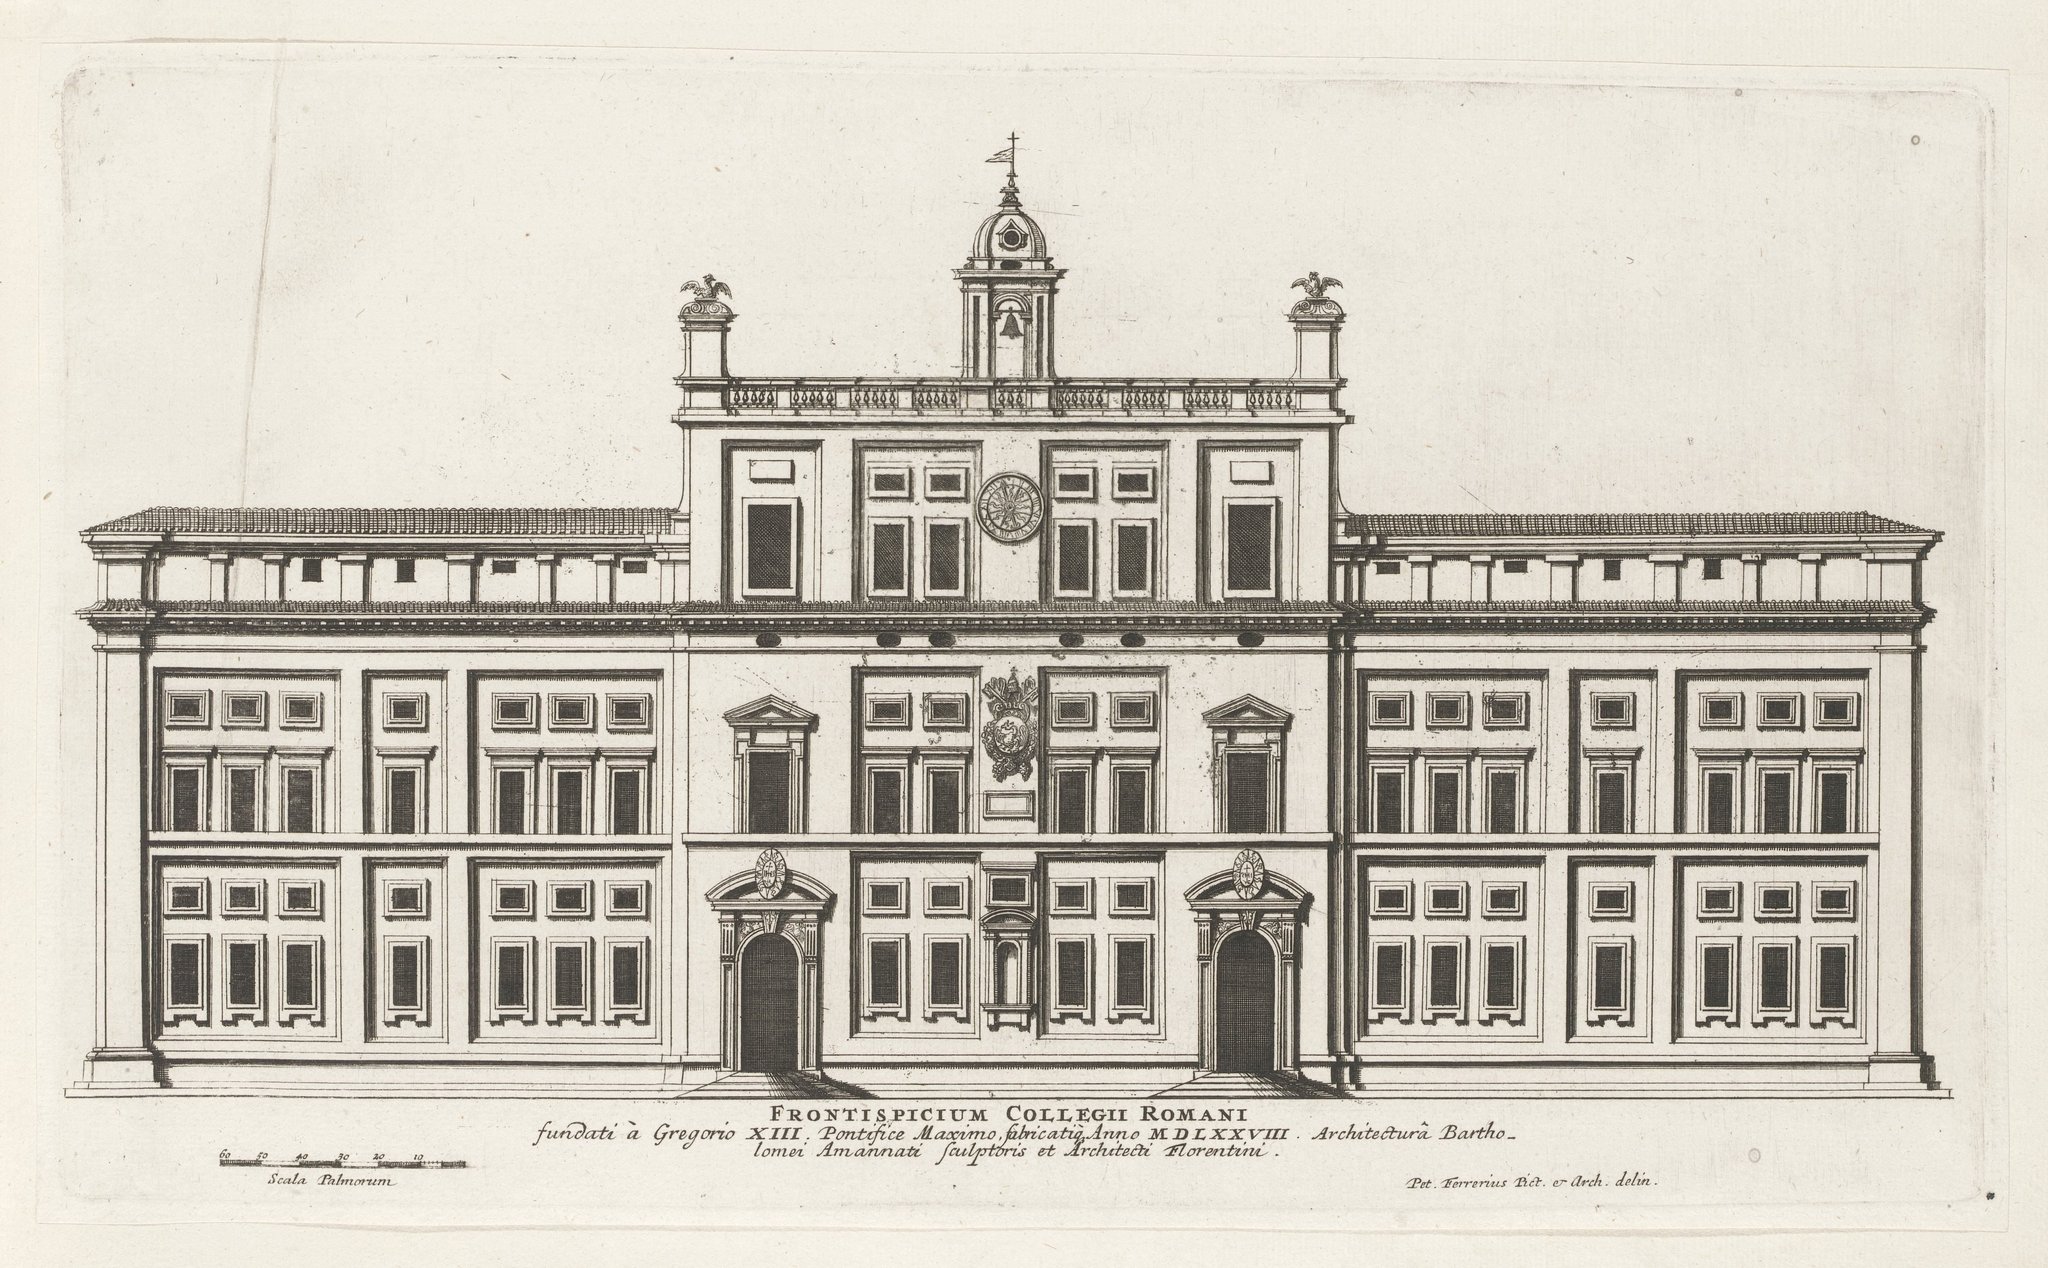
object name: album leaf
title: Palazzi di Roma dei più celebri architett (...)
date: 1655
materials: paper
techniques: etching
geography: rome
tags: rome, gregorius xiii, palace, façade (of house or building)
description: Deze prent maakt deel uit van de reeks getiteld: Palazzi di Roma. Deze reeks bestaat uit twee boeken. Boek één getiteld: Palazzi di Roma dei più celebri architetti..., bestaat uit 44 prenten die worden toegeschreven aan Giovanni Battista Falda (naam staat enkel op prent 27) en uitgegeven door Giovanni Giacomo de'Rossi. Deze 44 prenten zijn bekend in twee staten (met en zonder nummer). Boek twee getiteld: Nuovi disegni dell'architetture... libro secondo, bevat 66 prenten door Giovanni Battista Falda en Simone Felice. Deze 66 prenten zijn bekend in twee staten (met en zonder nummer).